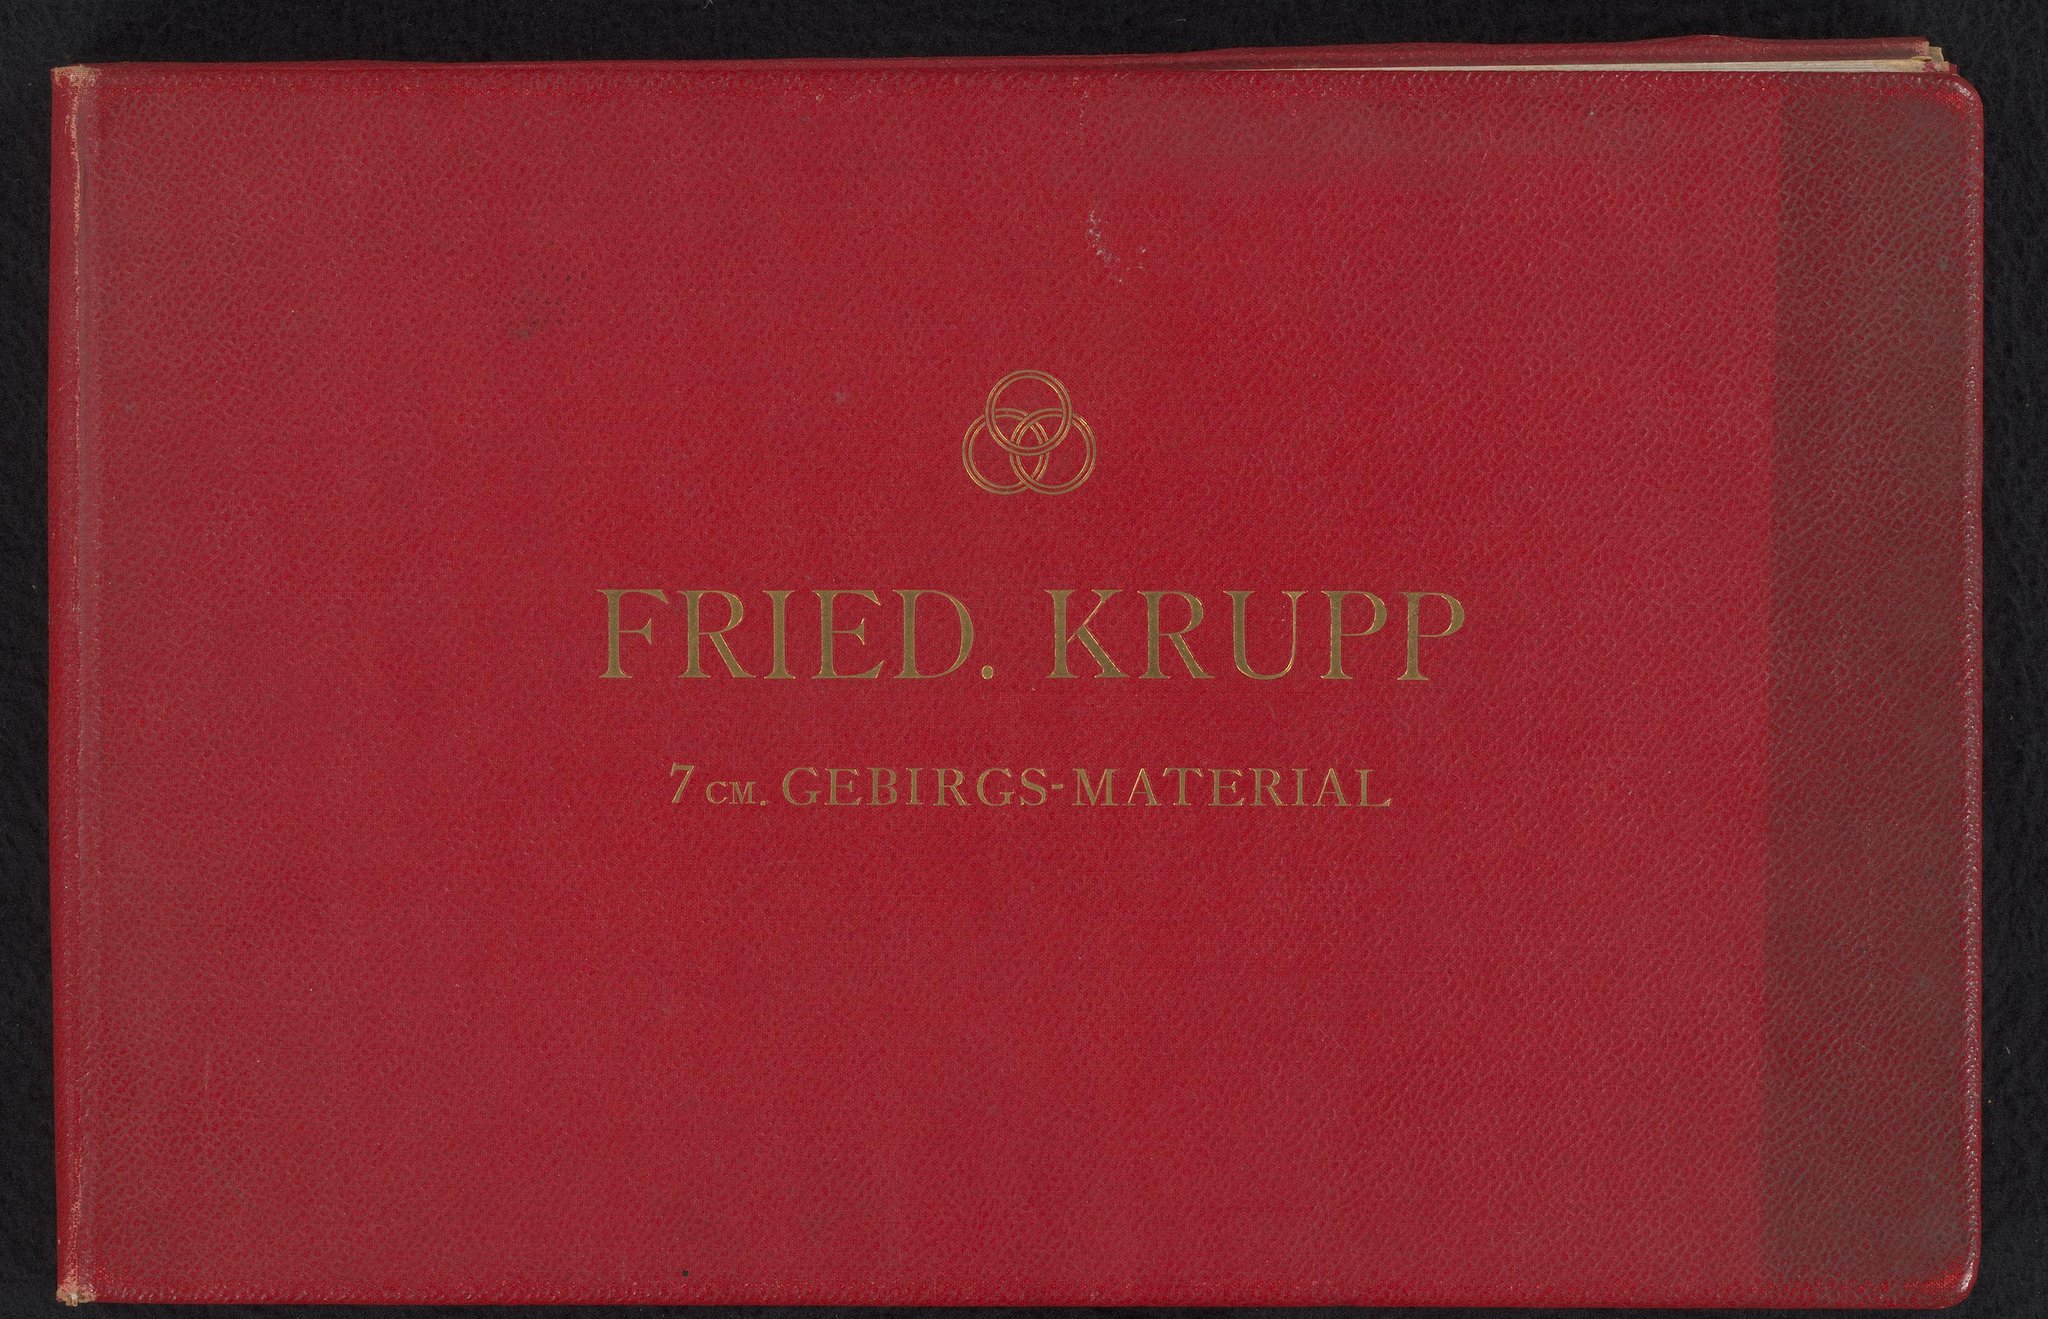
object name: photograph album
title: Fried. Krupp 7 cm. Gebirgs-Material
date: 1902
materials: cardboard, linen, paper, photographic support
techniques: collodion silver print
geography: essen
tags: handling of weapons ~ military training, firearms: cannon, animal mounts; pack-animals, mule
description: Rode verzamelmap met op de voorzijde de albumtitel en het bedrijfslogo van de firma Fried. Krupp. Schutbladen en stofflappen zijn van gegaufreerd papier. Het album bevat acht kartonnen kaarten met in totaal twaalf foto's; elke kaart is voorzien van een gedrukte titel. De opnames werden gemaakt door het Photogr. Atelier der Gussstahlfabrik von Fried. Krupp, een in Essen gevestigd staalbedrijf. De afdrukken tonen het L/14 bergkanon (kaliber 7 cm) en de wijze waarop dit in delen getransporteerd kon worden op de rug van lastdieren. Voor de foto's is gebruik gemaakt van opgezette dieren.